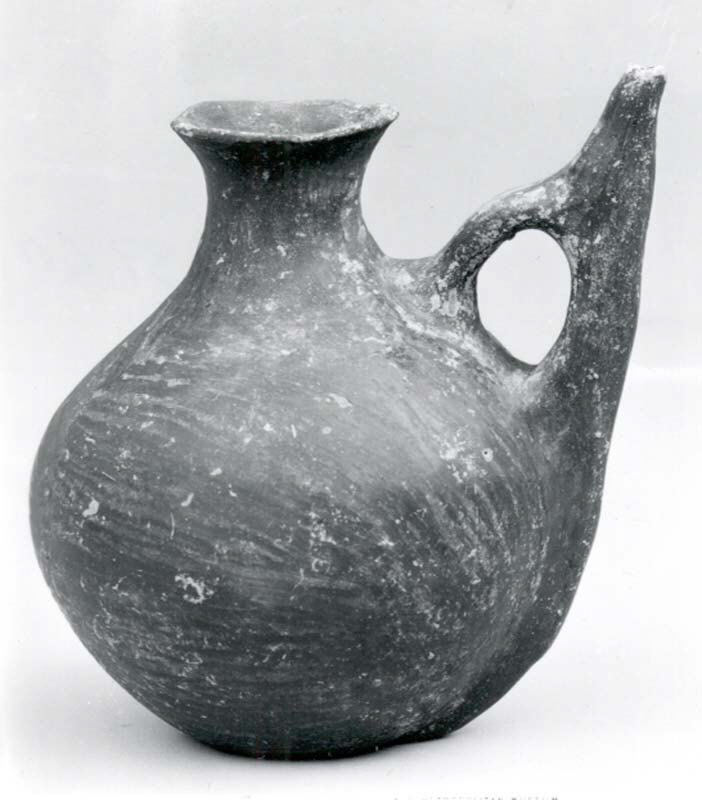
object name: jug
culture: iranian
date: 900-700 BCE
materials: ceramic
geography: iran